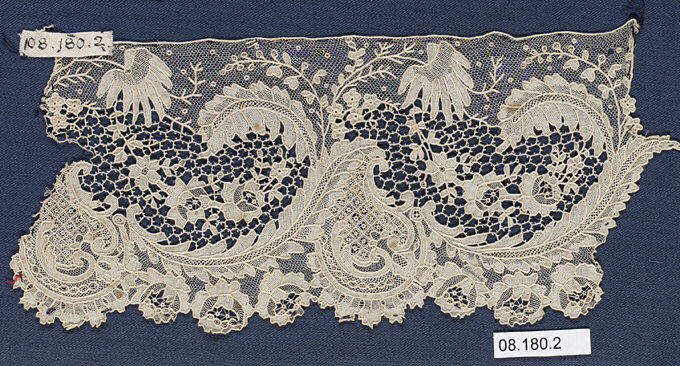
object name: fragment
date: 1801-1900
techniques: lace